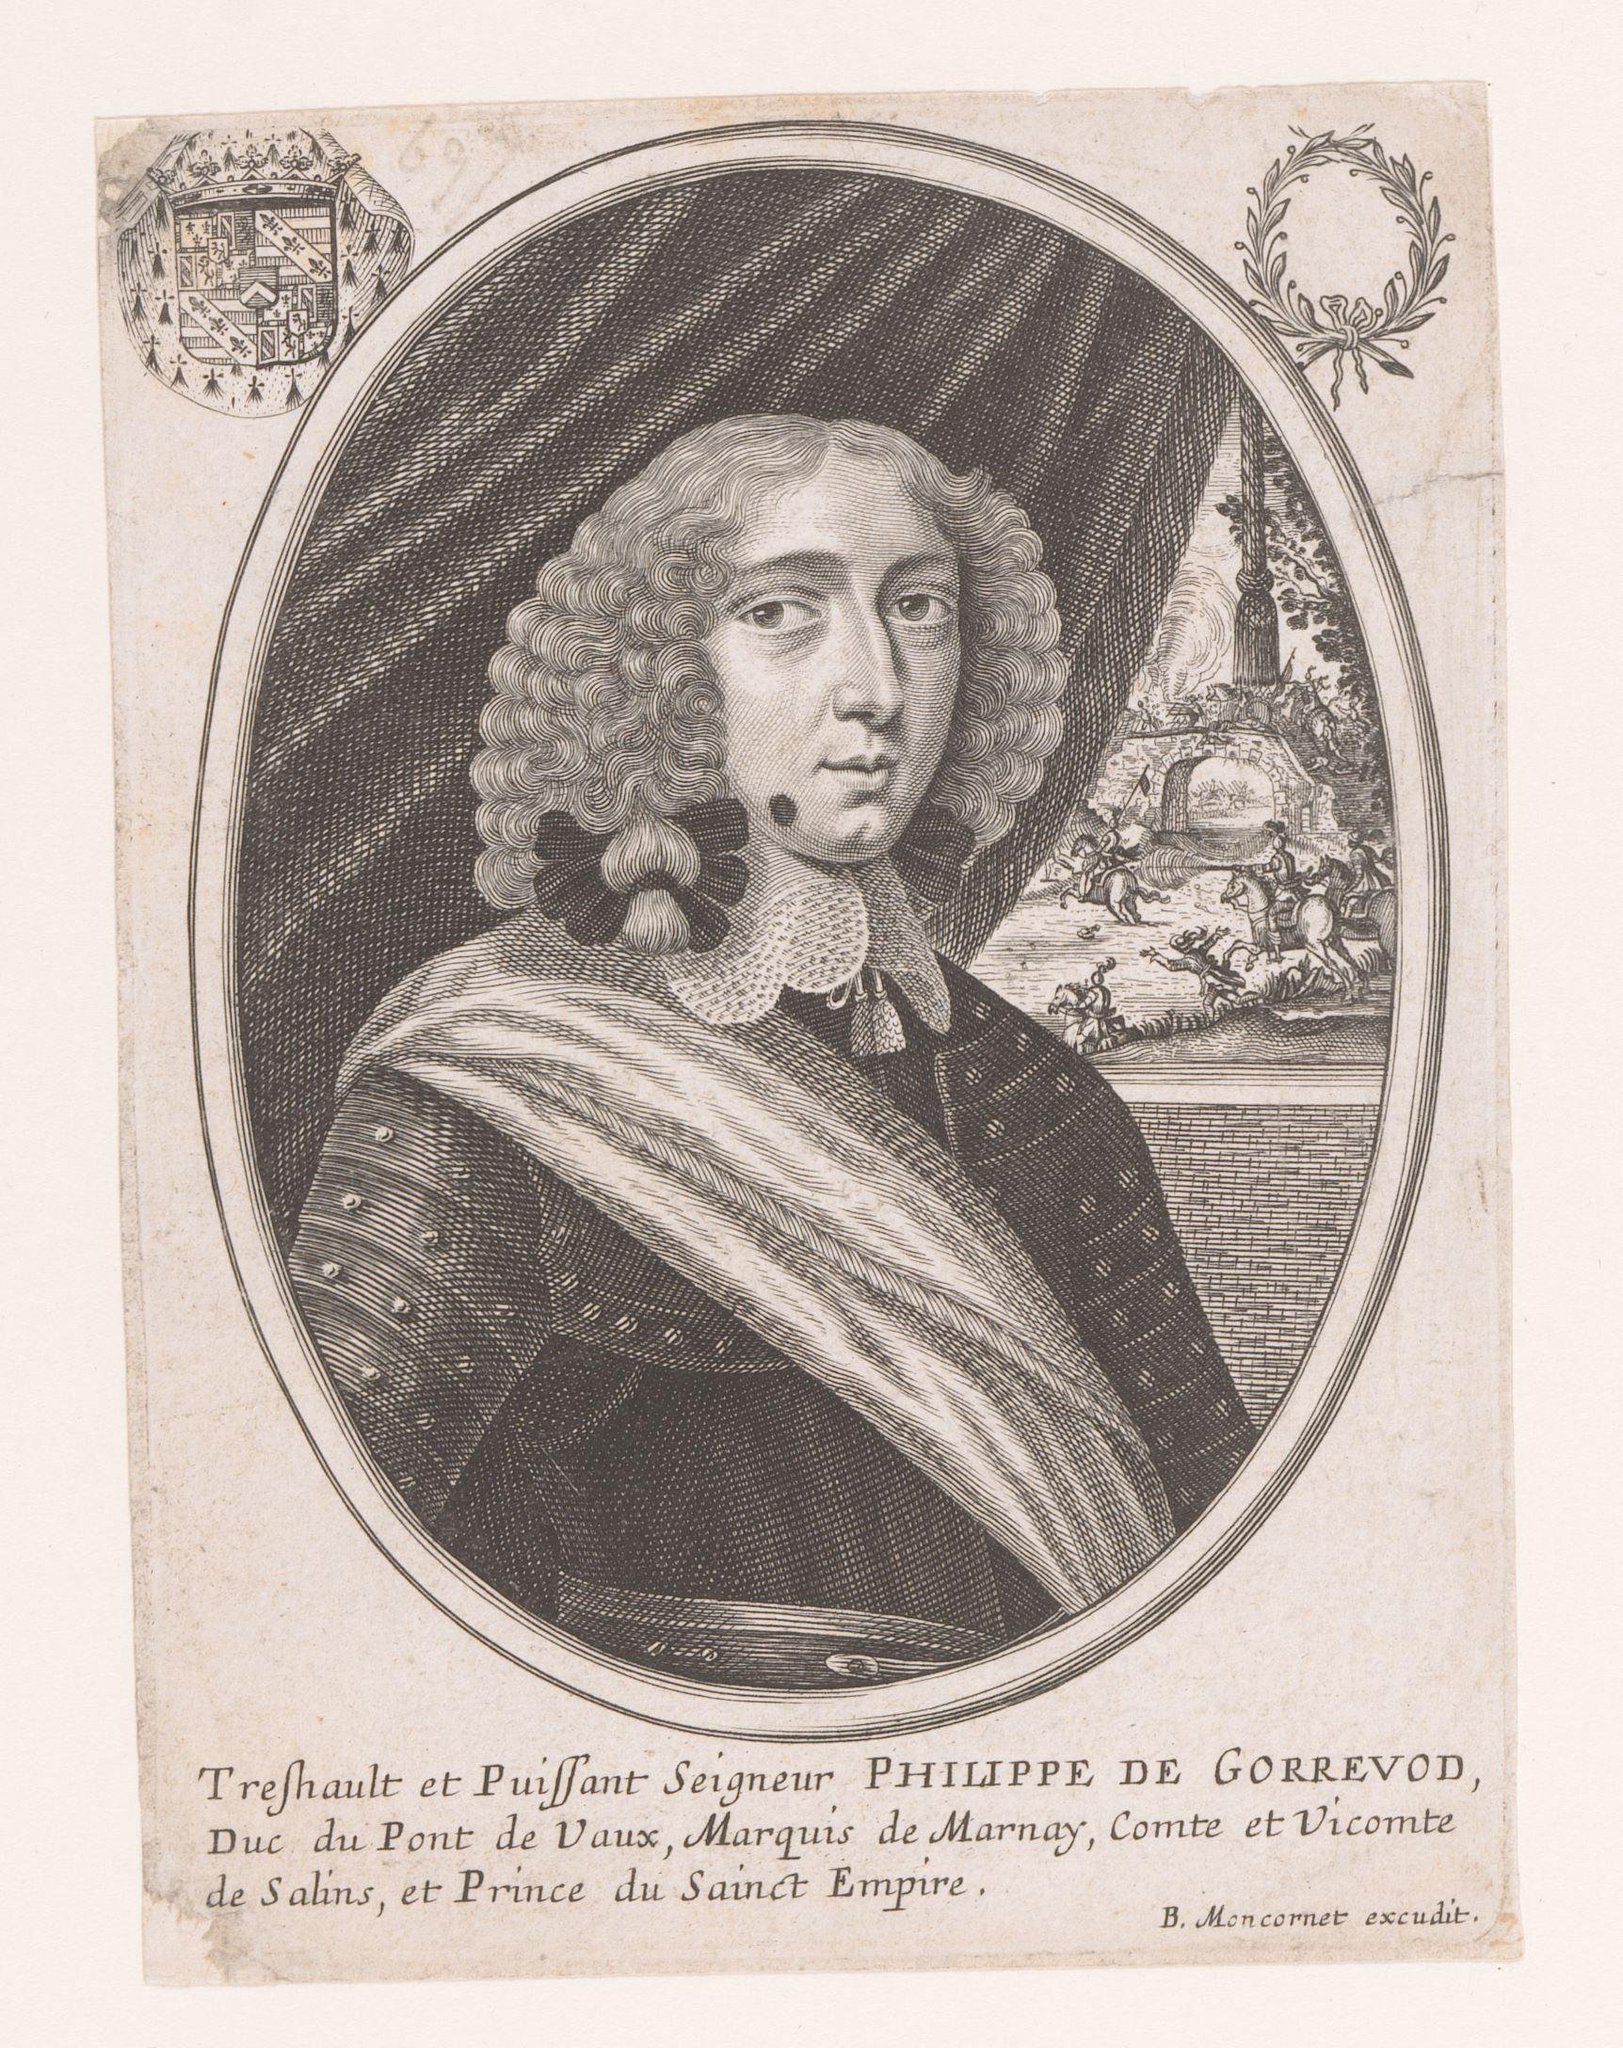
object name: print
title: Portret van Philippe de Gorrevod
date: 1610-1668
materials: paper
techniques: engraving, etching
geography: paris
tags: historical persons, nobility and patriciate; chivalry, knighthood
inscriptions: collector's mark: Lugt 2228